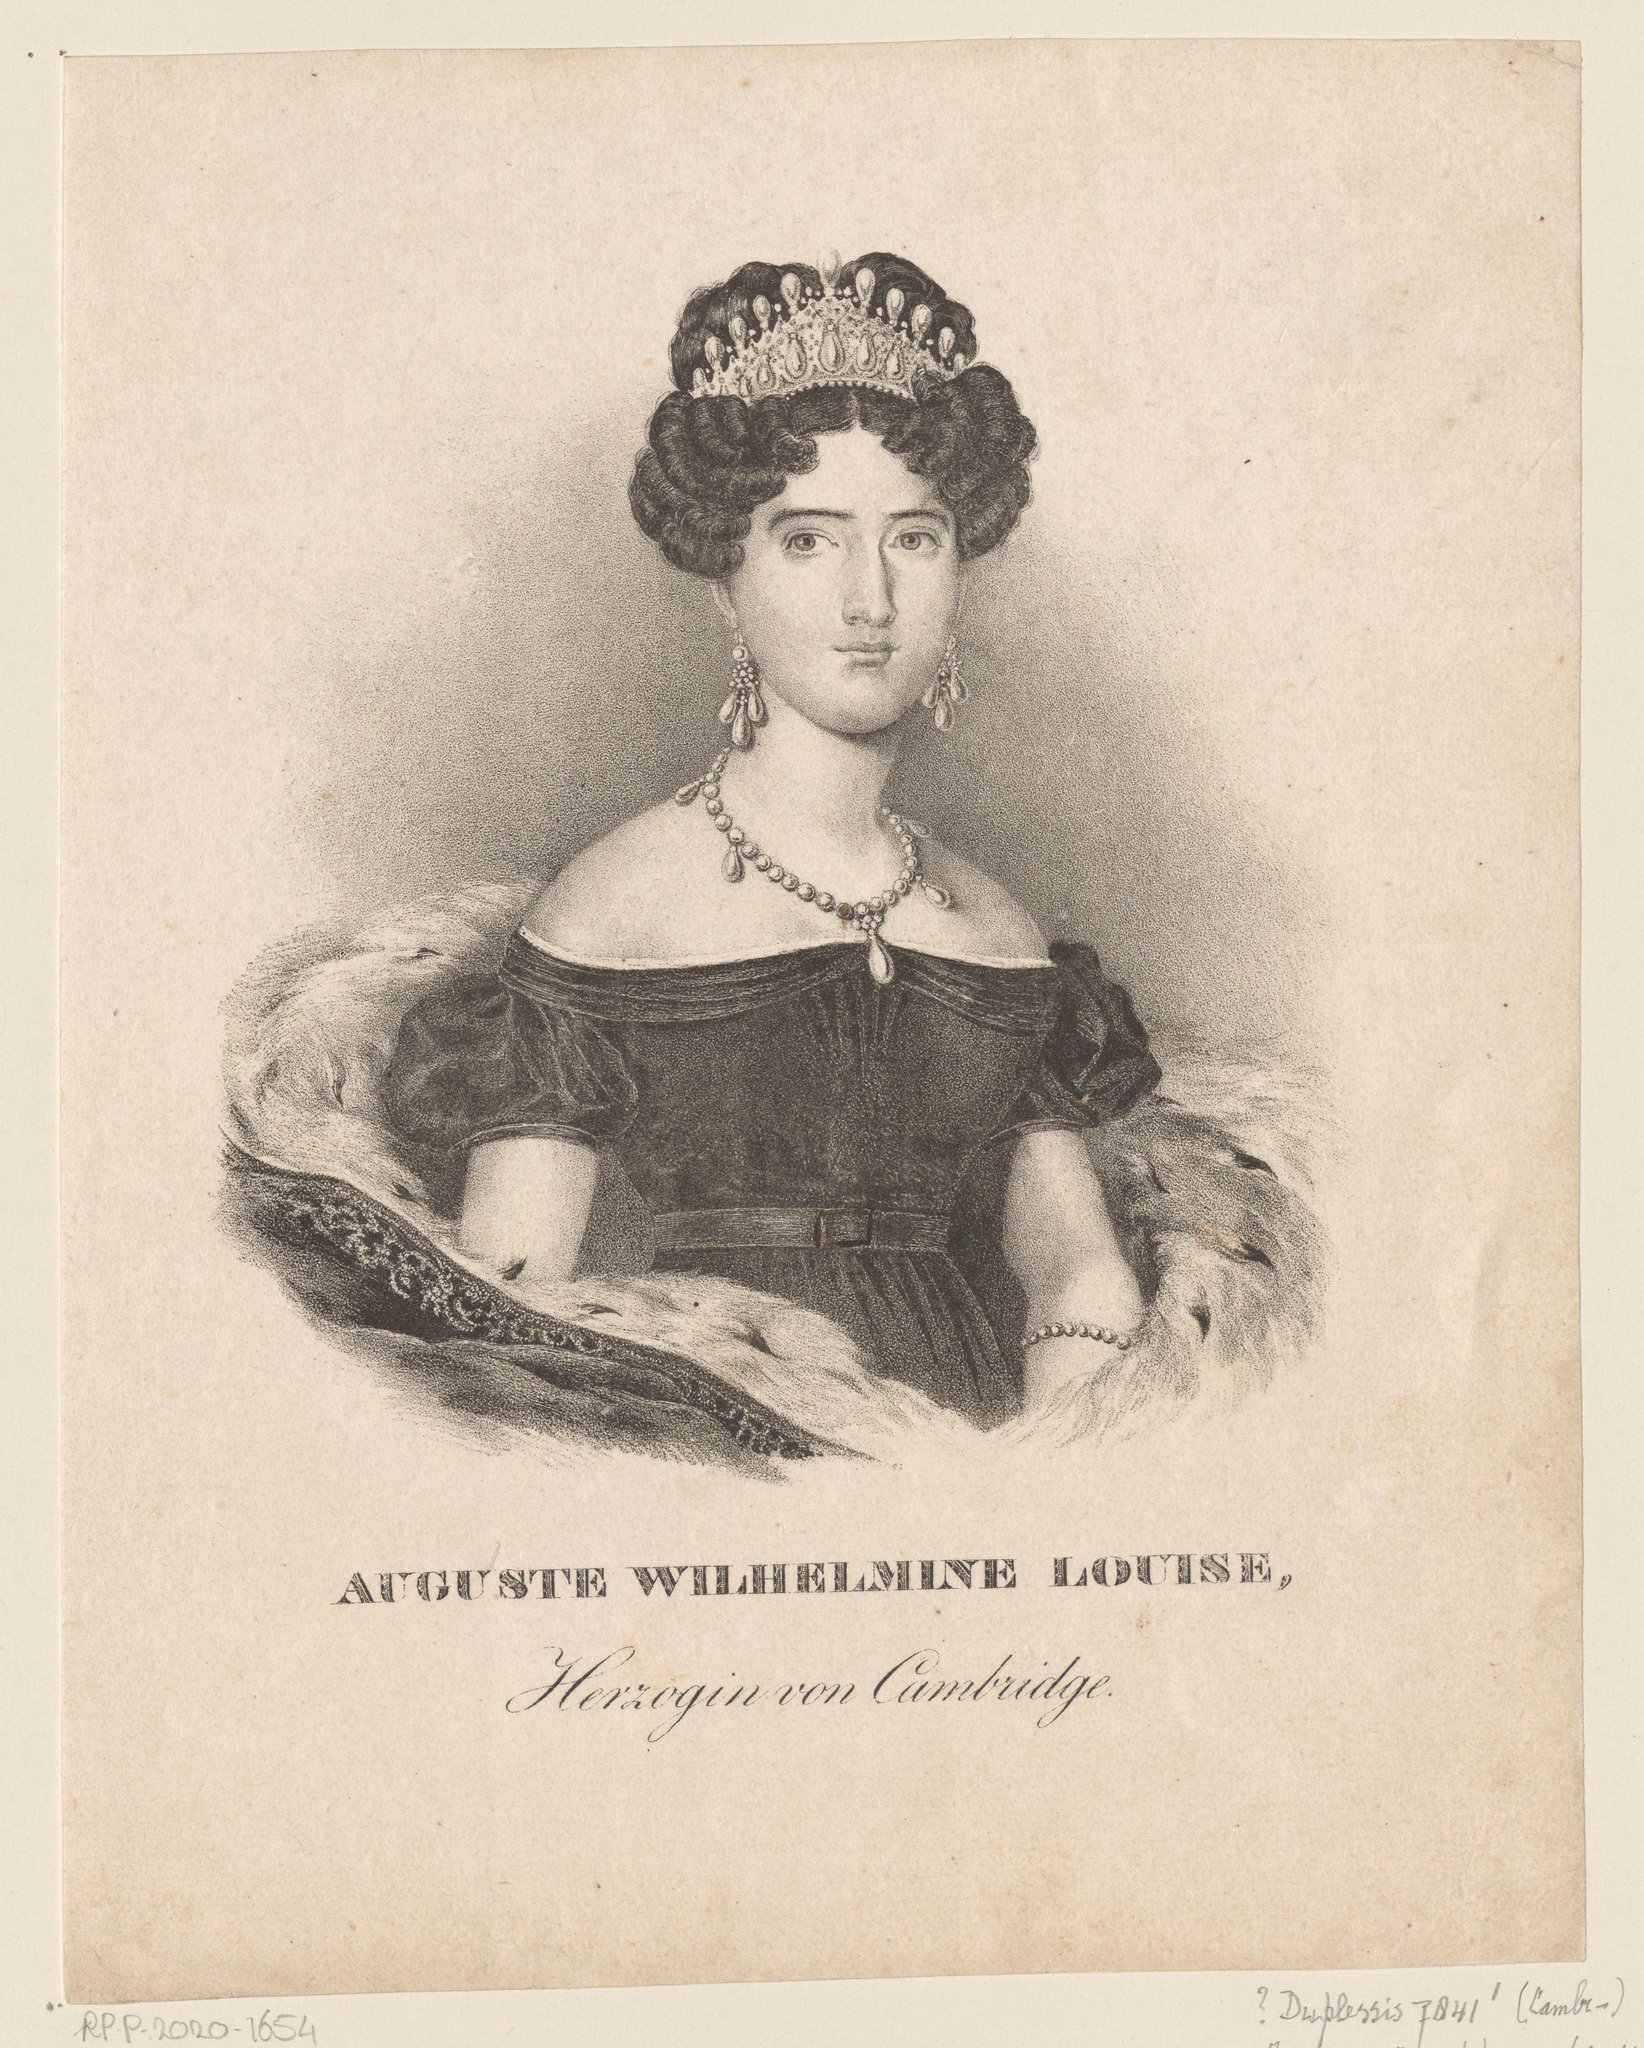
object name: print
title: Portret van Augusta van Hessen-Kassel, hertogin van Cambridge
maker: Anonymous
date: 1818-1899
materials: paper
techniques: lithograph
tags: historical persons